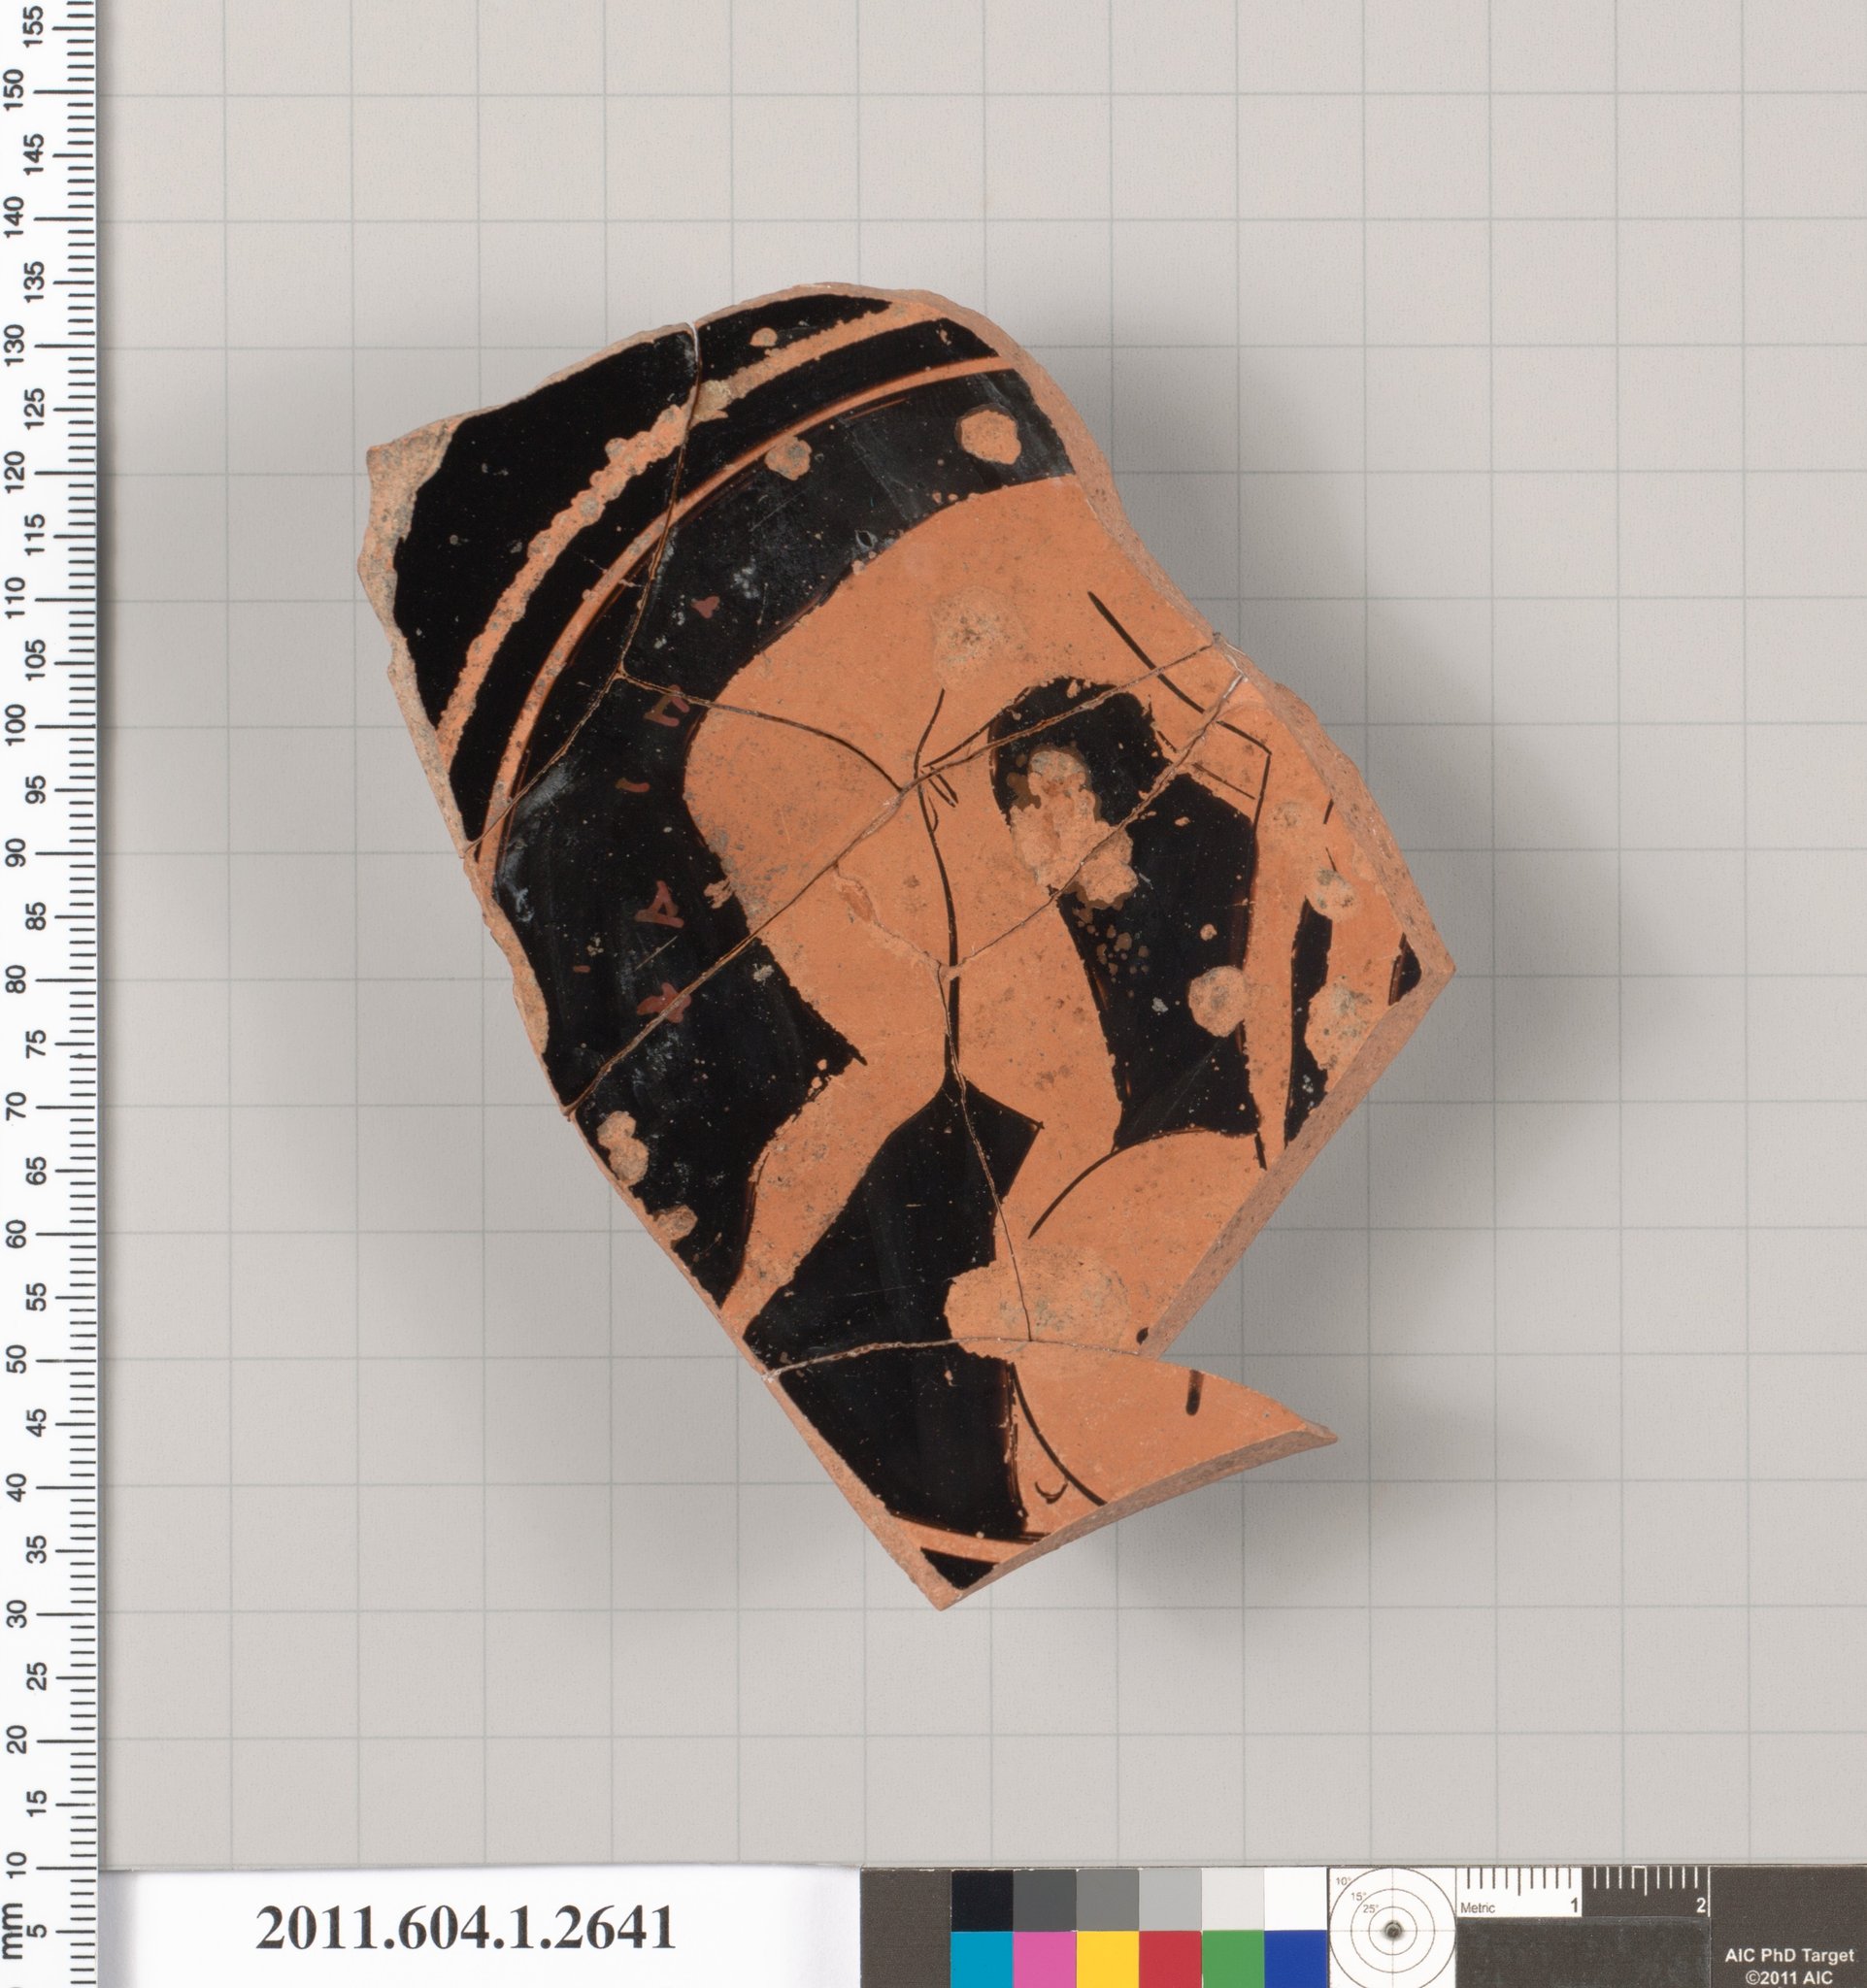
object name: kylix fragment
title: Terracotta fragment of a kylix (drinking cup)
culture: greek, attic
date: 520-500 BCE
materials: terracotta